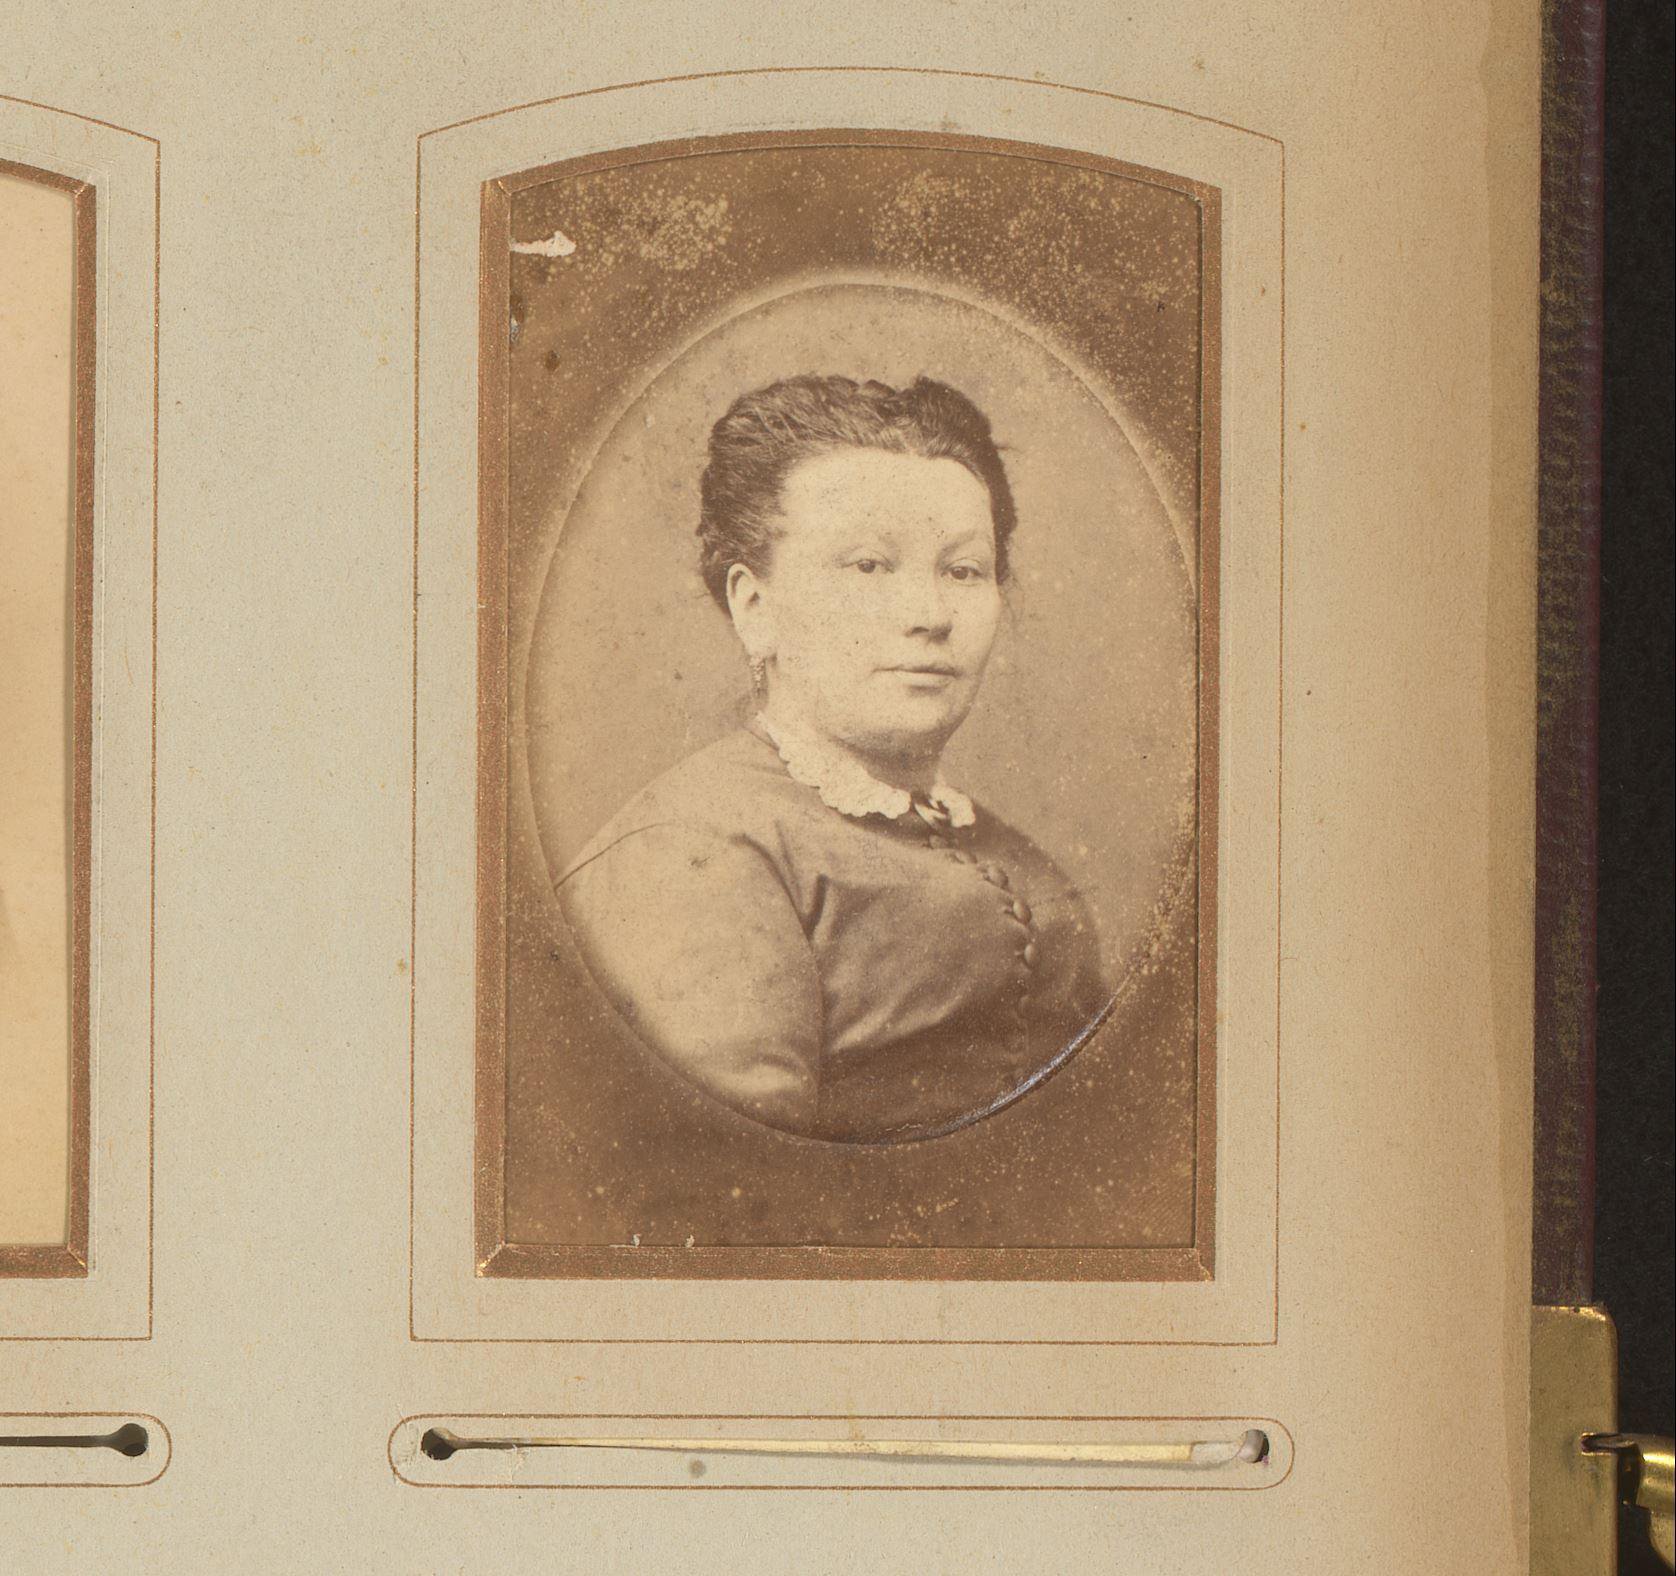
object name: photograph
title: Portret van een vrouw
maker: ed. radermacher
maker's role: fotograaf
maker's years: 1839-1908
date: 1863-1890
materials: cardboard, photographic support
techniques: albumen print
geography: rotterdam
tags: historical persons - bb - woman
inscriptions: inscription: ‘ED. RADERMACHER/ PHOTOGRAPH/ FIRMA/ JANSSENS & RADERMACHER/ KRUISKADE, HOEK KERKLAAN/ ROTTERDAM’